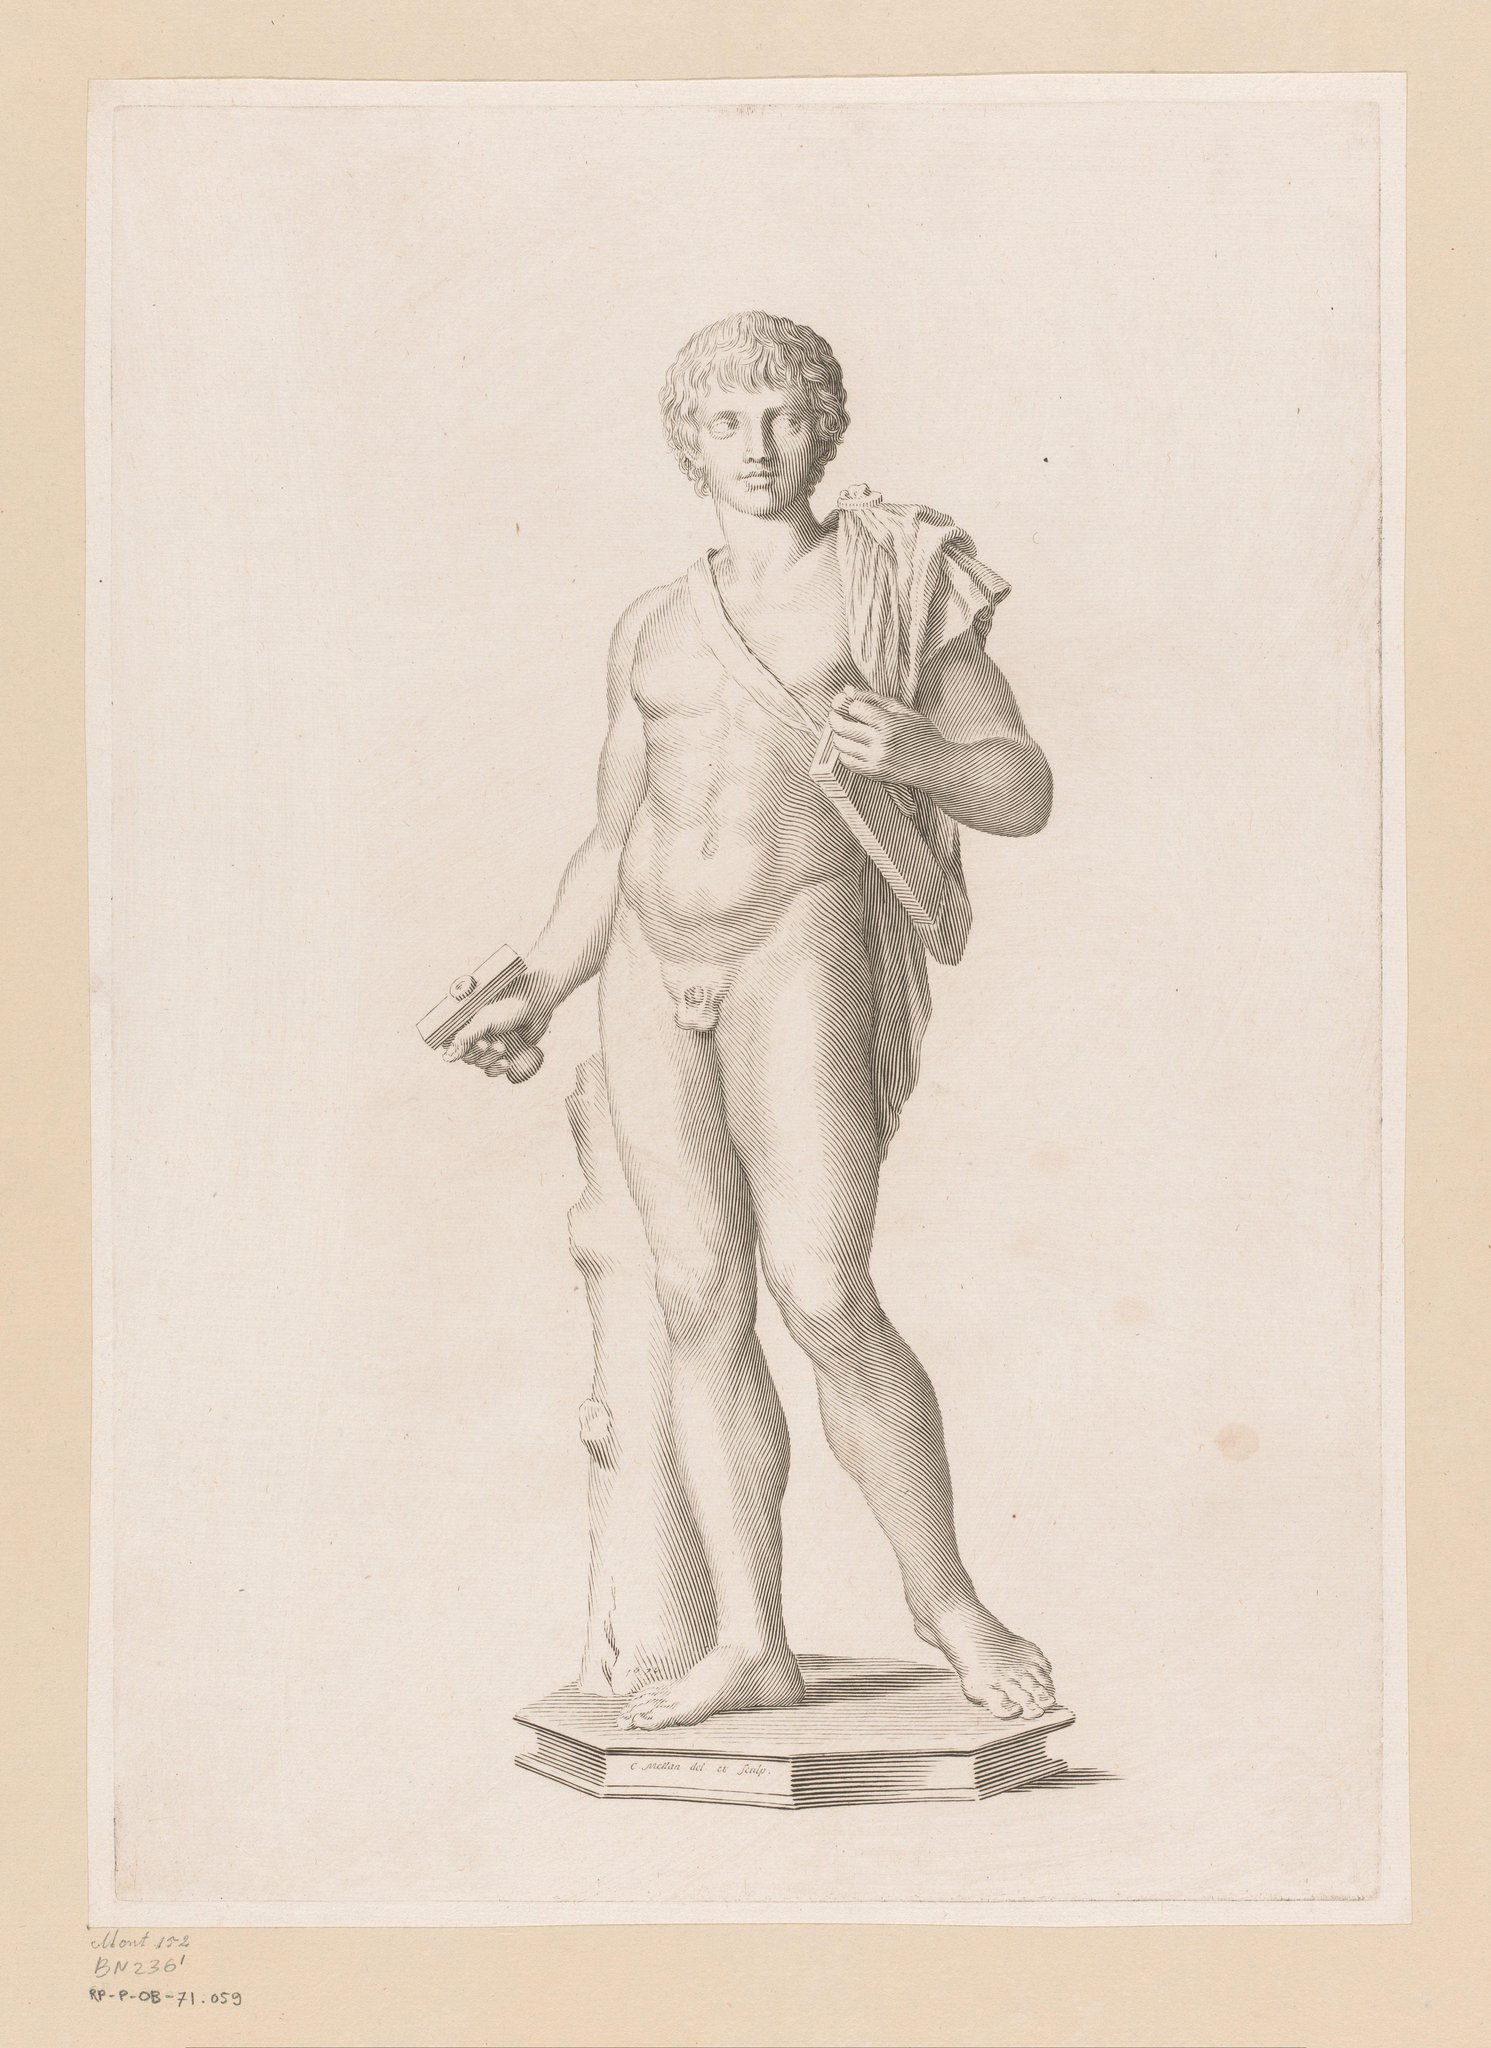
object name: print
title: Standbeeld van een jonge gladiator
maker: claude mellan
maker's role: draughtsman, print maker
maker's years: 1598-1688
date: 1670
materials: paper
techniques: engraving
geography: paris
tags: the (nude) human figure; 'corpo humano' (ripa), piece of sculpture, reproduction of a piece of sculpture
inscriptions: collector's mark: Lugt 240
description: Prent gebruikt voor: Félibien, André. Tableaux du Cabinet du roy. Statues et bustes antiques des maisons royales. Parijs: Imprimerie Royale, 1677. Het boek bevat 61 prenten van beelden en bustes uit Franse koninklijke collectie. Mellan vervaardigde in totaal achttien platen (zie ook British Museum, inv.nr. 1874,0808.1488). De verblijfplaats van het beeld is onbekend.